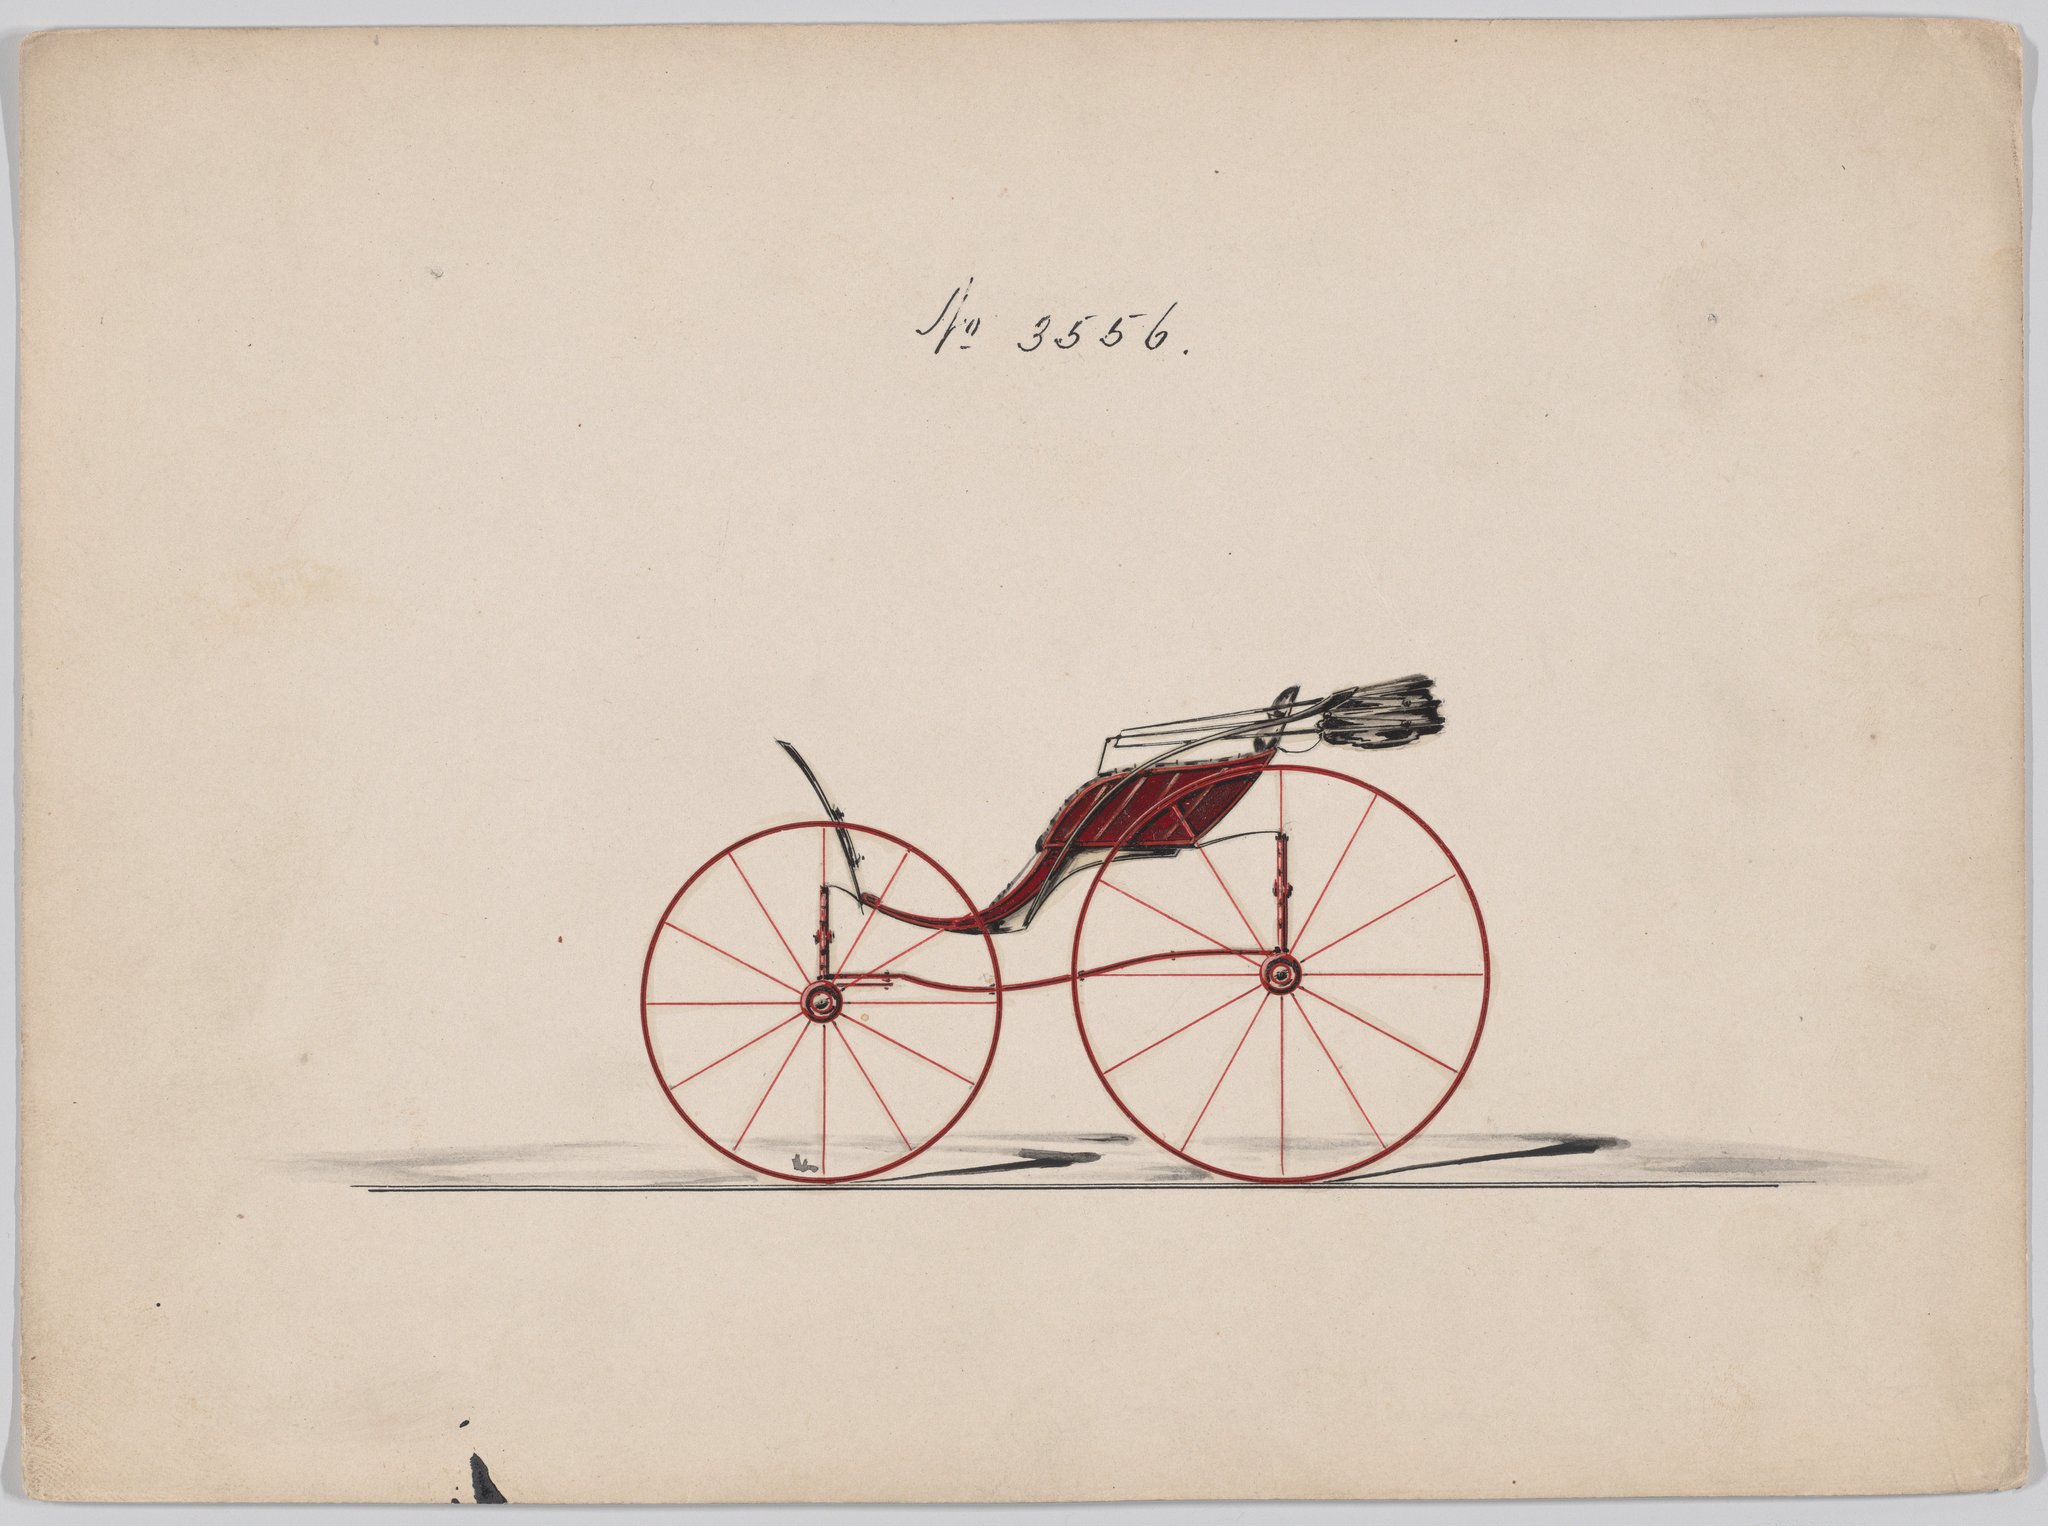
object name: drawing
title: Design for Pony Phaeton, no. 3556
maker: brewster & co.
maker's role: manufacturer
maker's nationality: american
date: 1870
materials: gouache, gum arabic, ink, watercolor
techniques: pen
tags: carriages